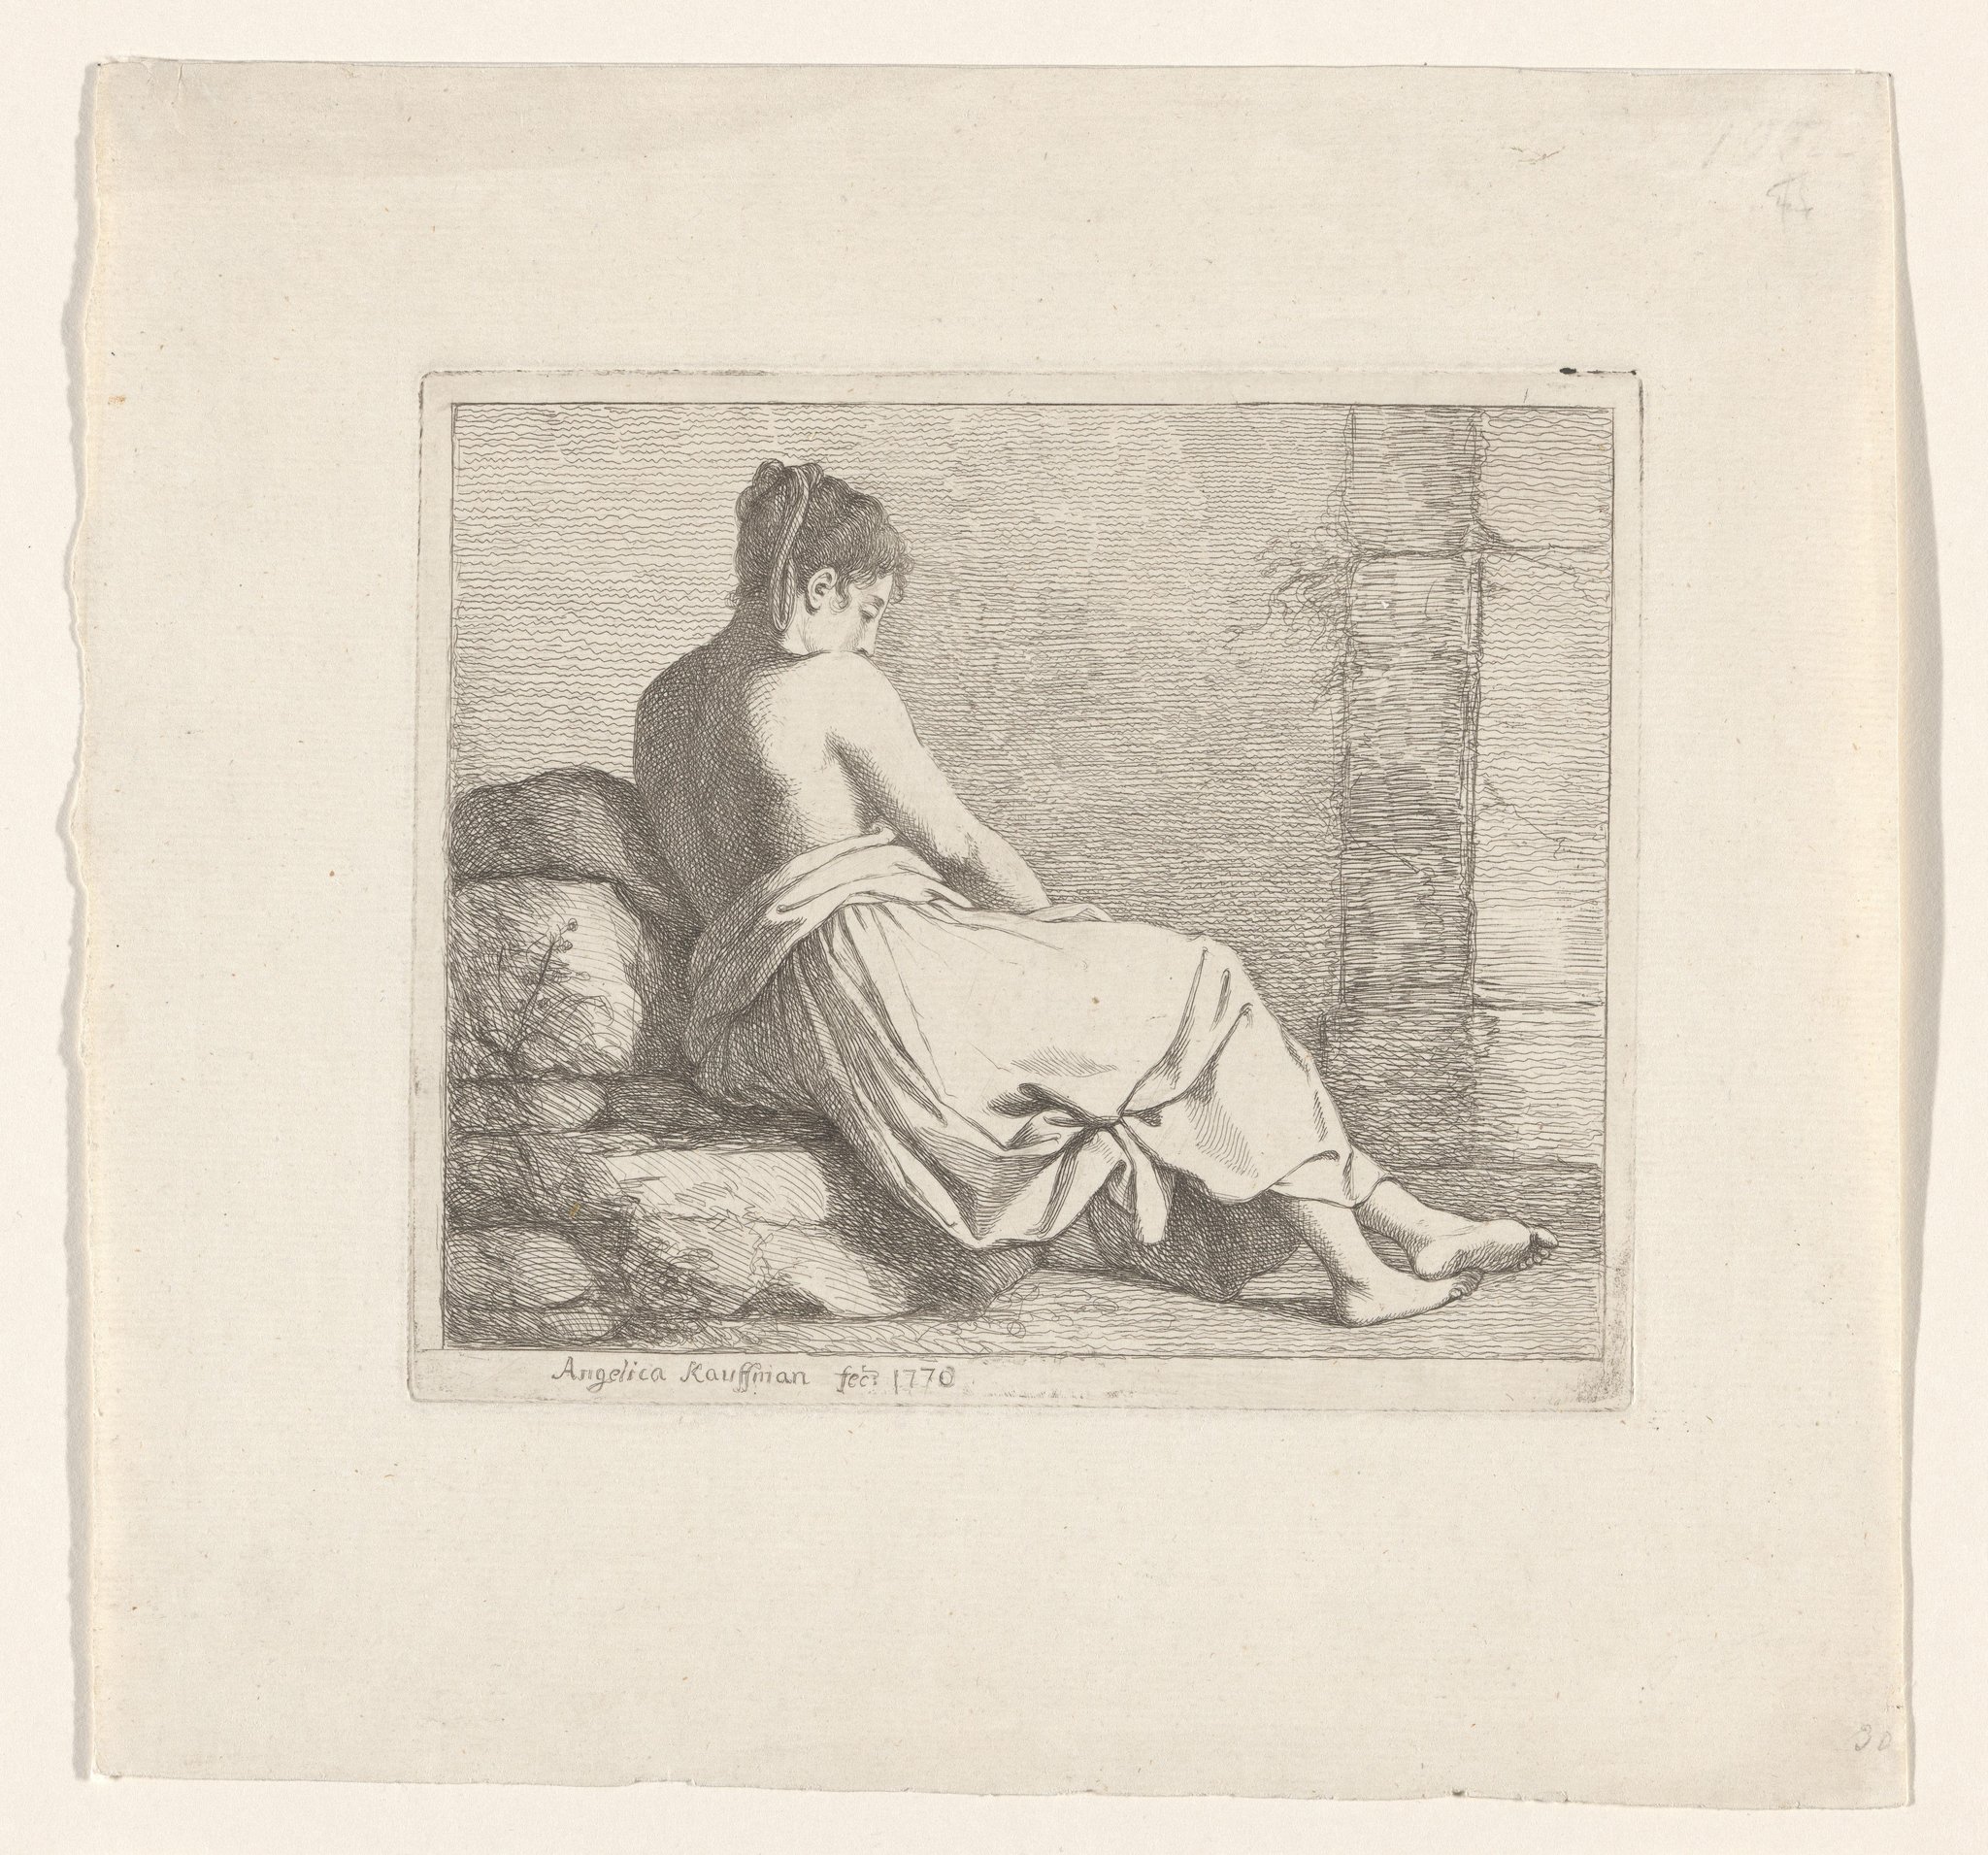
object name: print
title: Halfnaakte vrouw van achteren gezien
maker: angelica kauffmann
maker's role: draughtsman, print maker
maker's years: 1741-1807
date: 1770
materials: ink, paper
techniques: etching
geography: london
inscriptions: date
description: Halfnaakte vrouw leunend op een aantal stenen van achteren gezien.